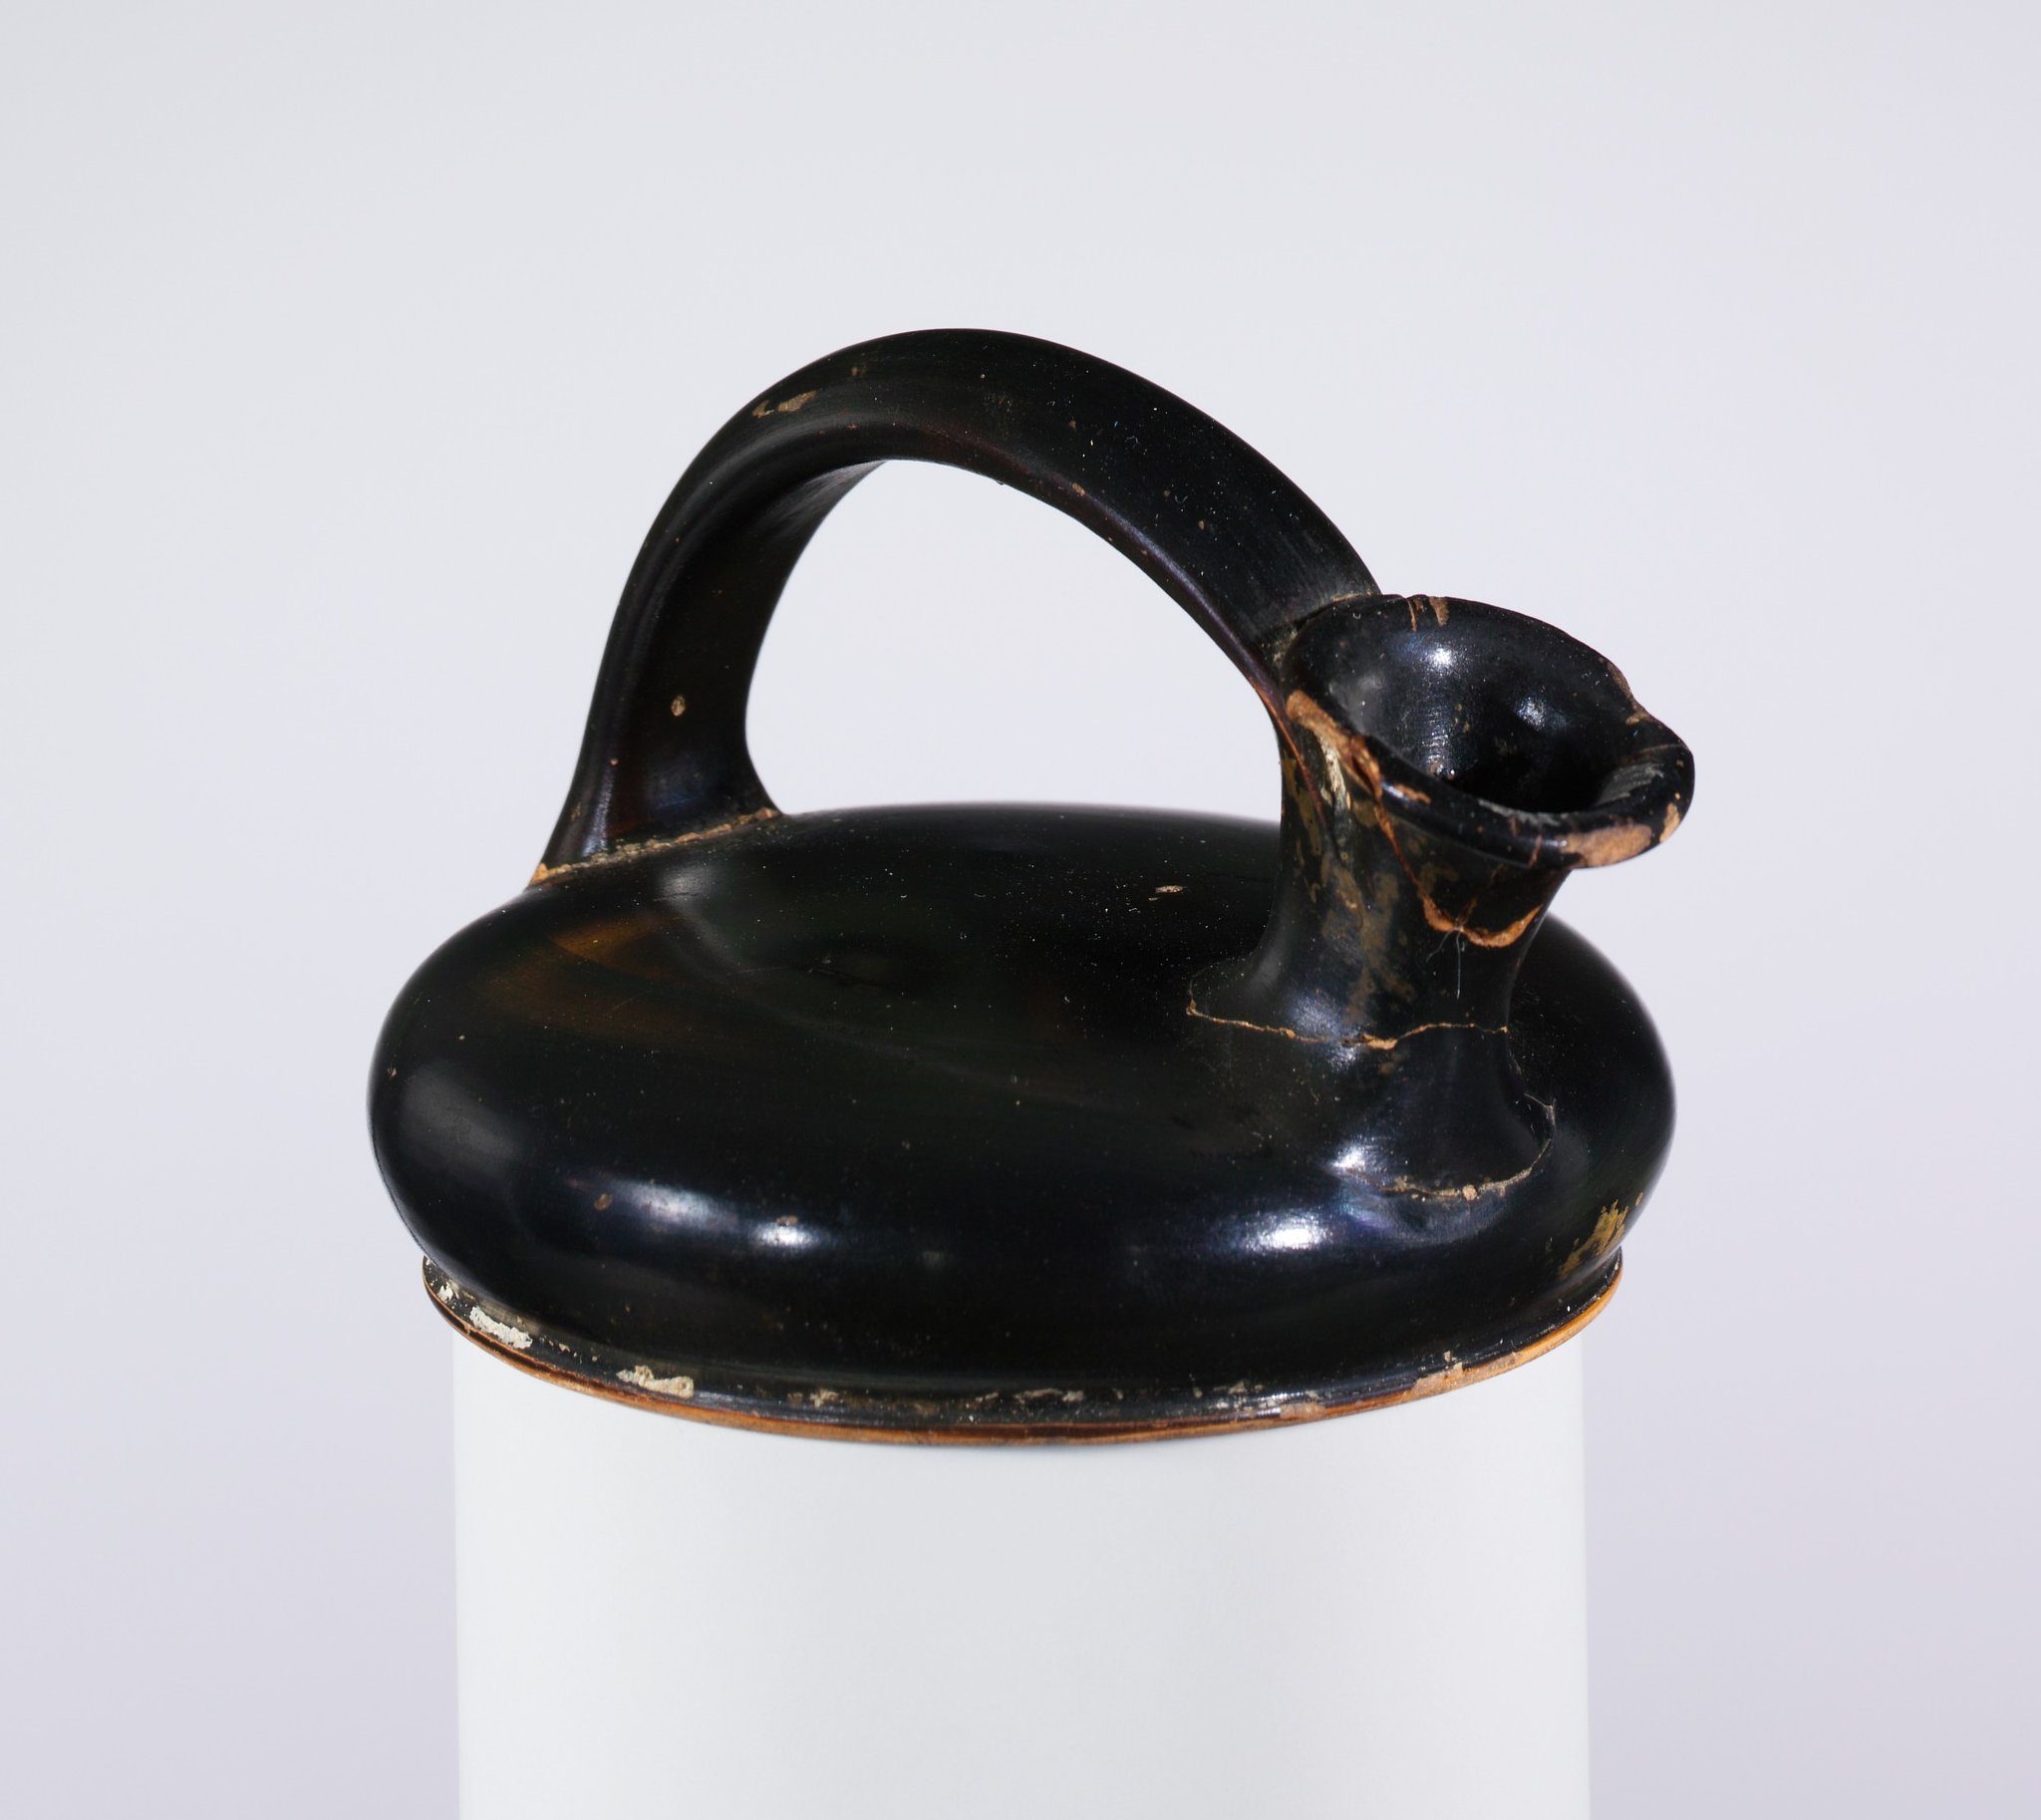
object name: askos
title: Terracotta askos (flask with a spout and handle over the top)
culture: greek, attic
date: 467-435 BCE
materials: terracotta